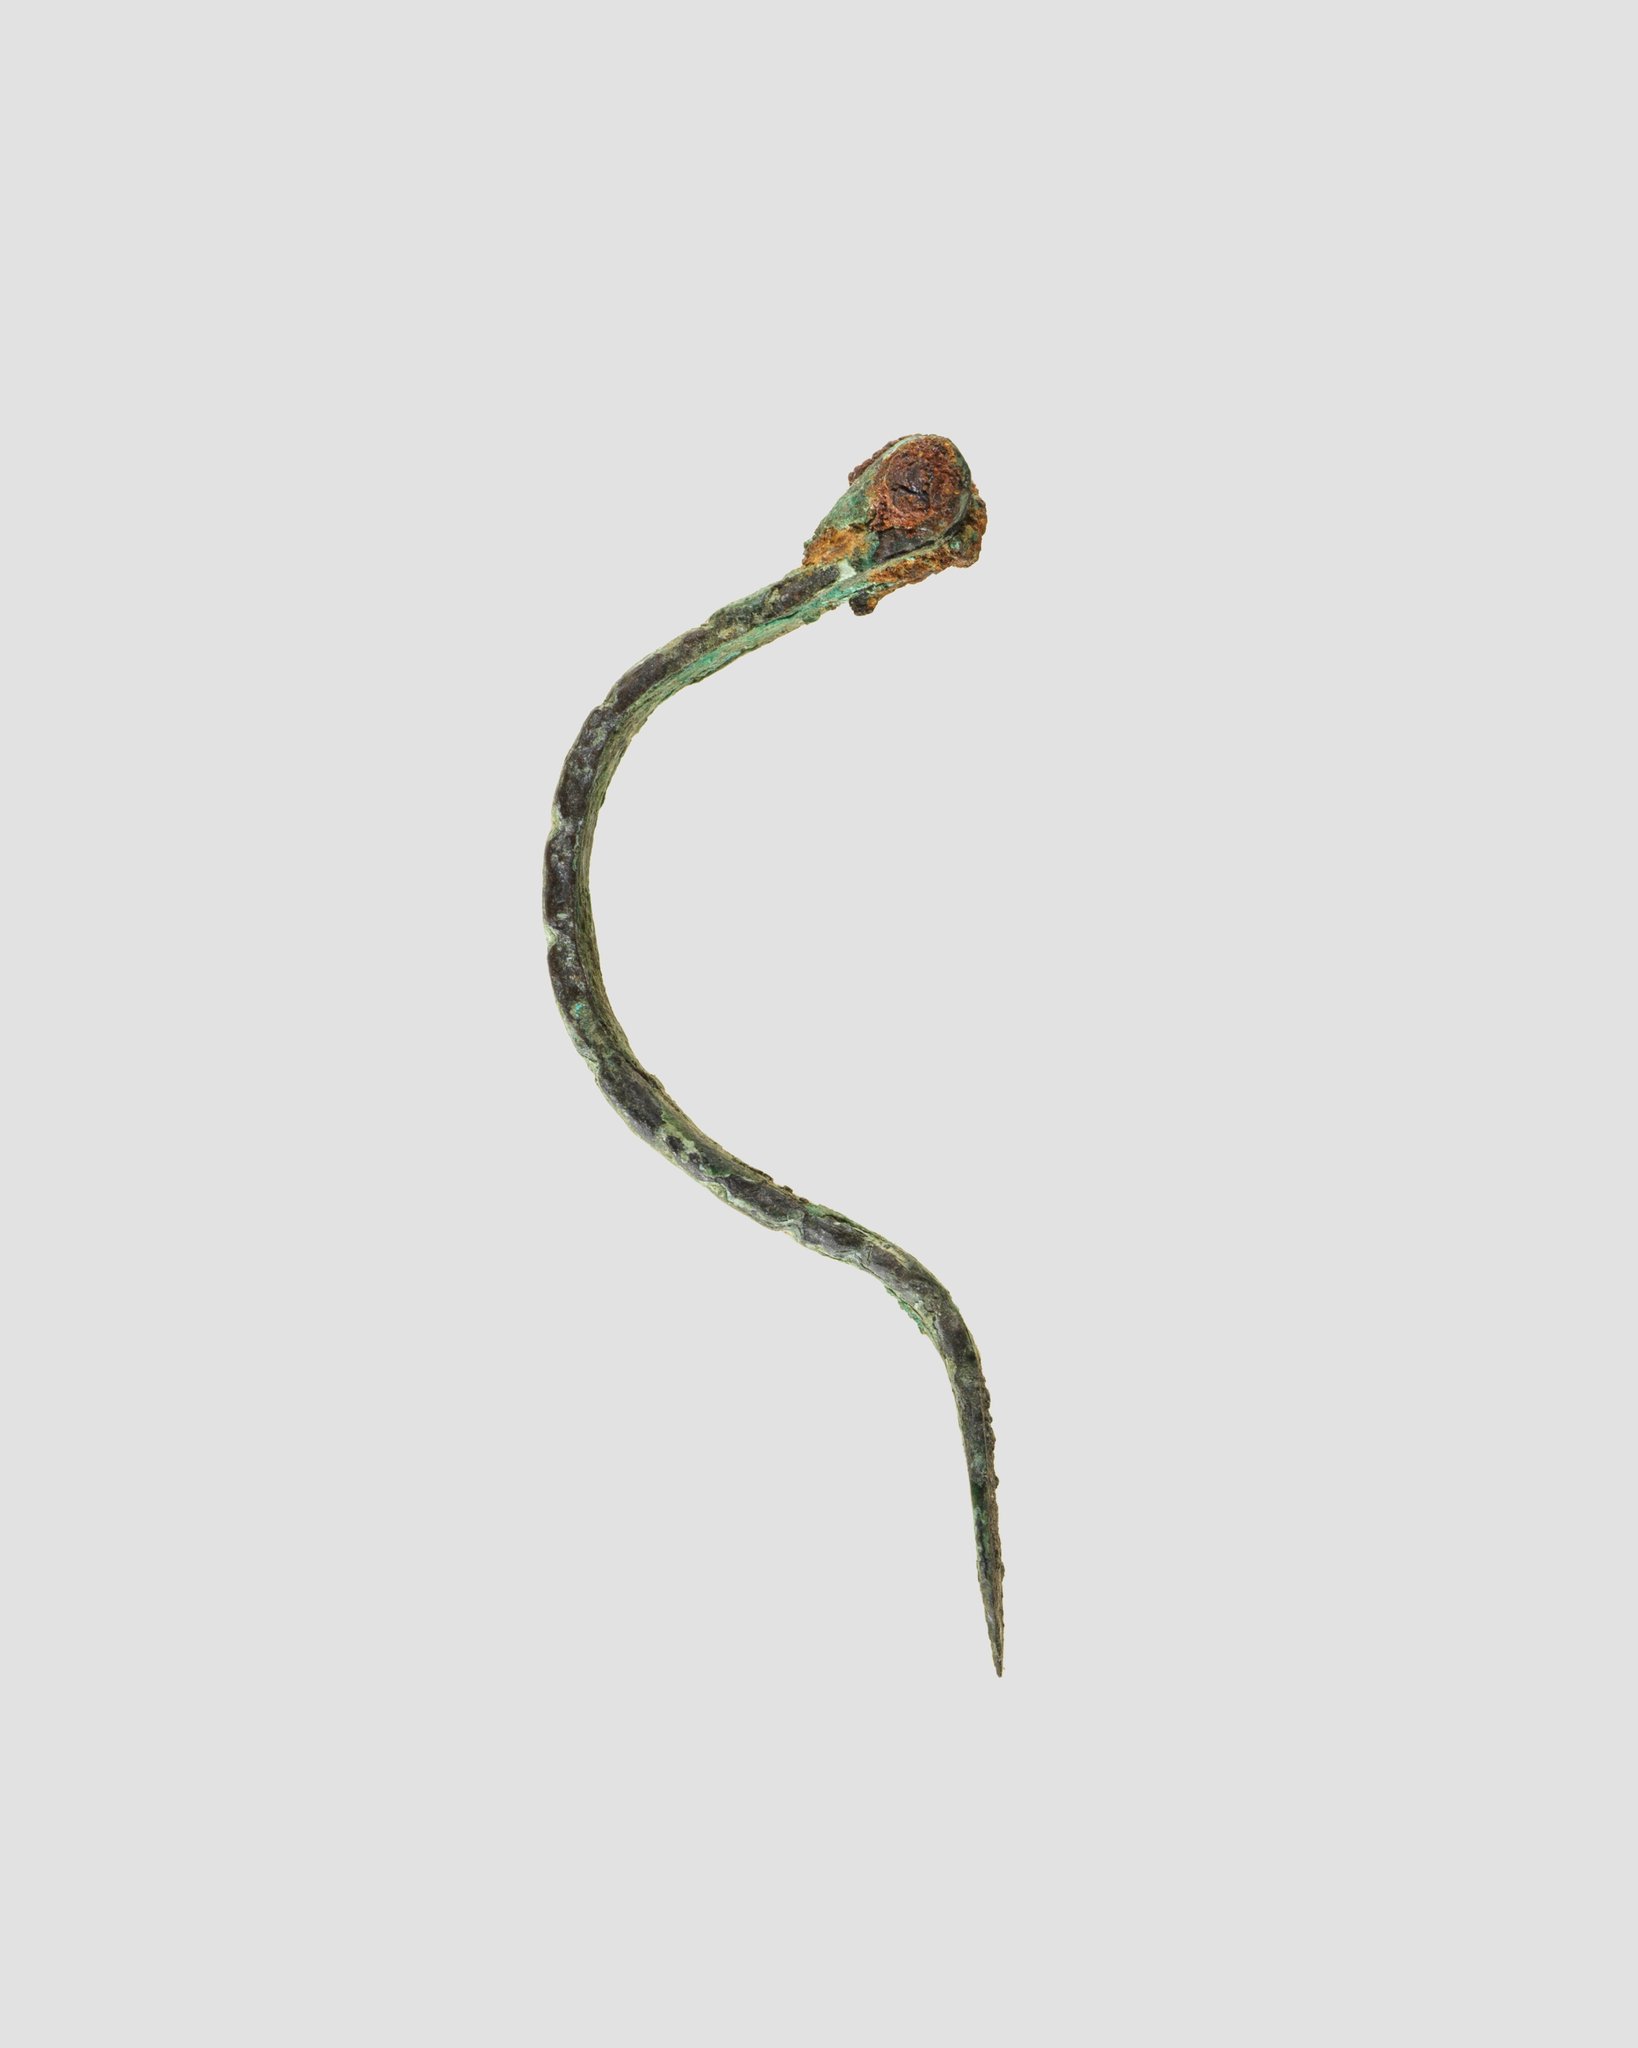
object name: pin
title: Bronze clothing pin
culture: alanic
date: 601-900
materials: metal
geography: caucasus